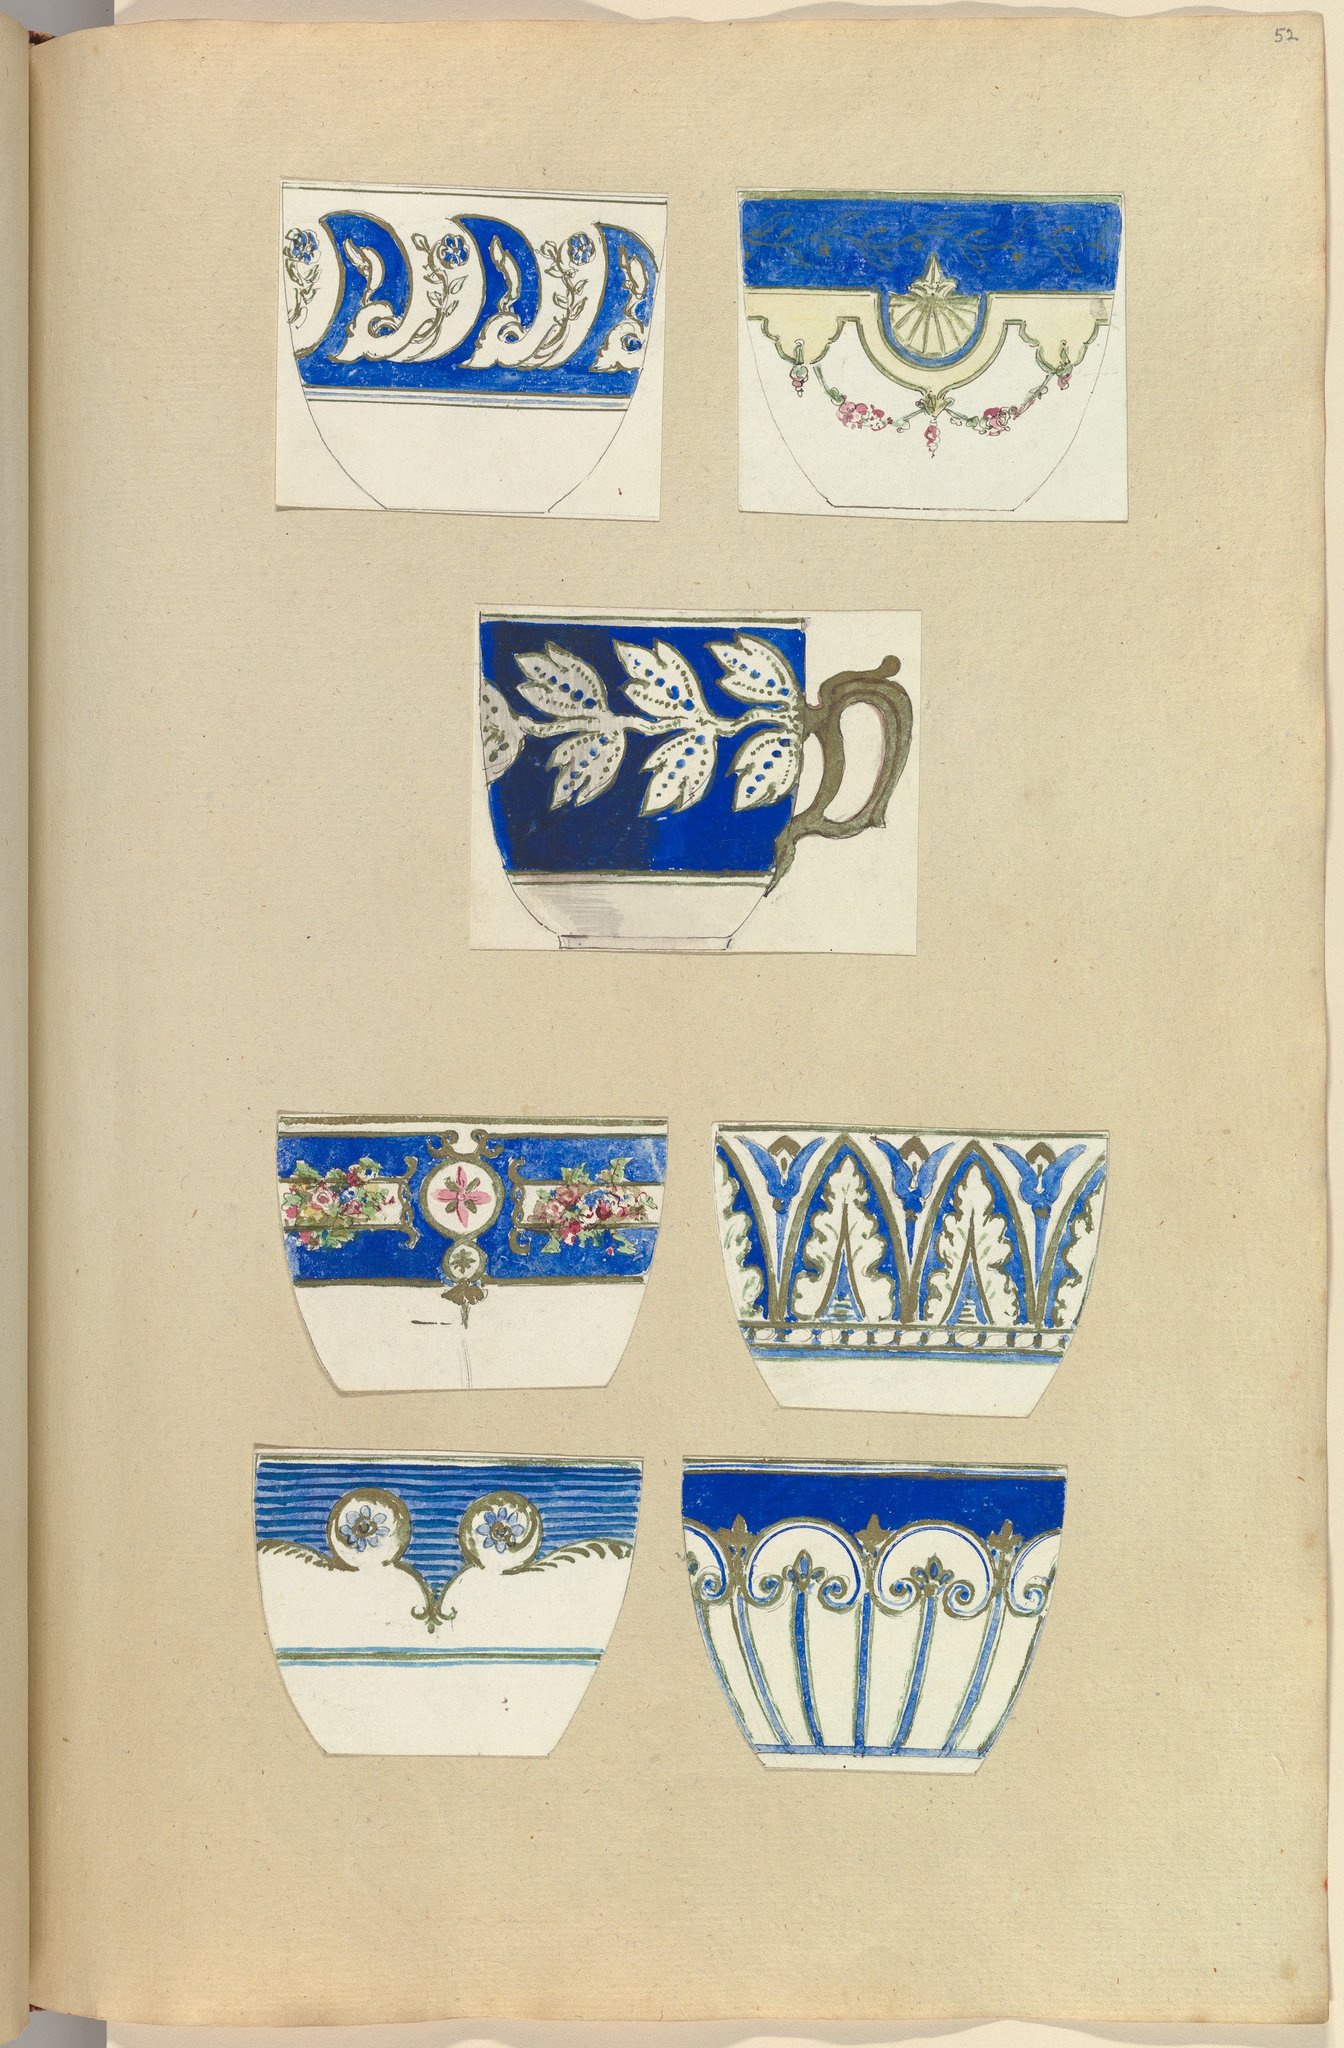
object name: drawing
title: Seven Designs for Decorated Cups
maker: alfred henry forrester [alfred crowquill]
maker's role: artist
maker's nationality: british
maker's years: 1804-1872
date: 1845-1855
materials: ink, watercolor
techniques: pen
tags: cups